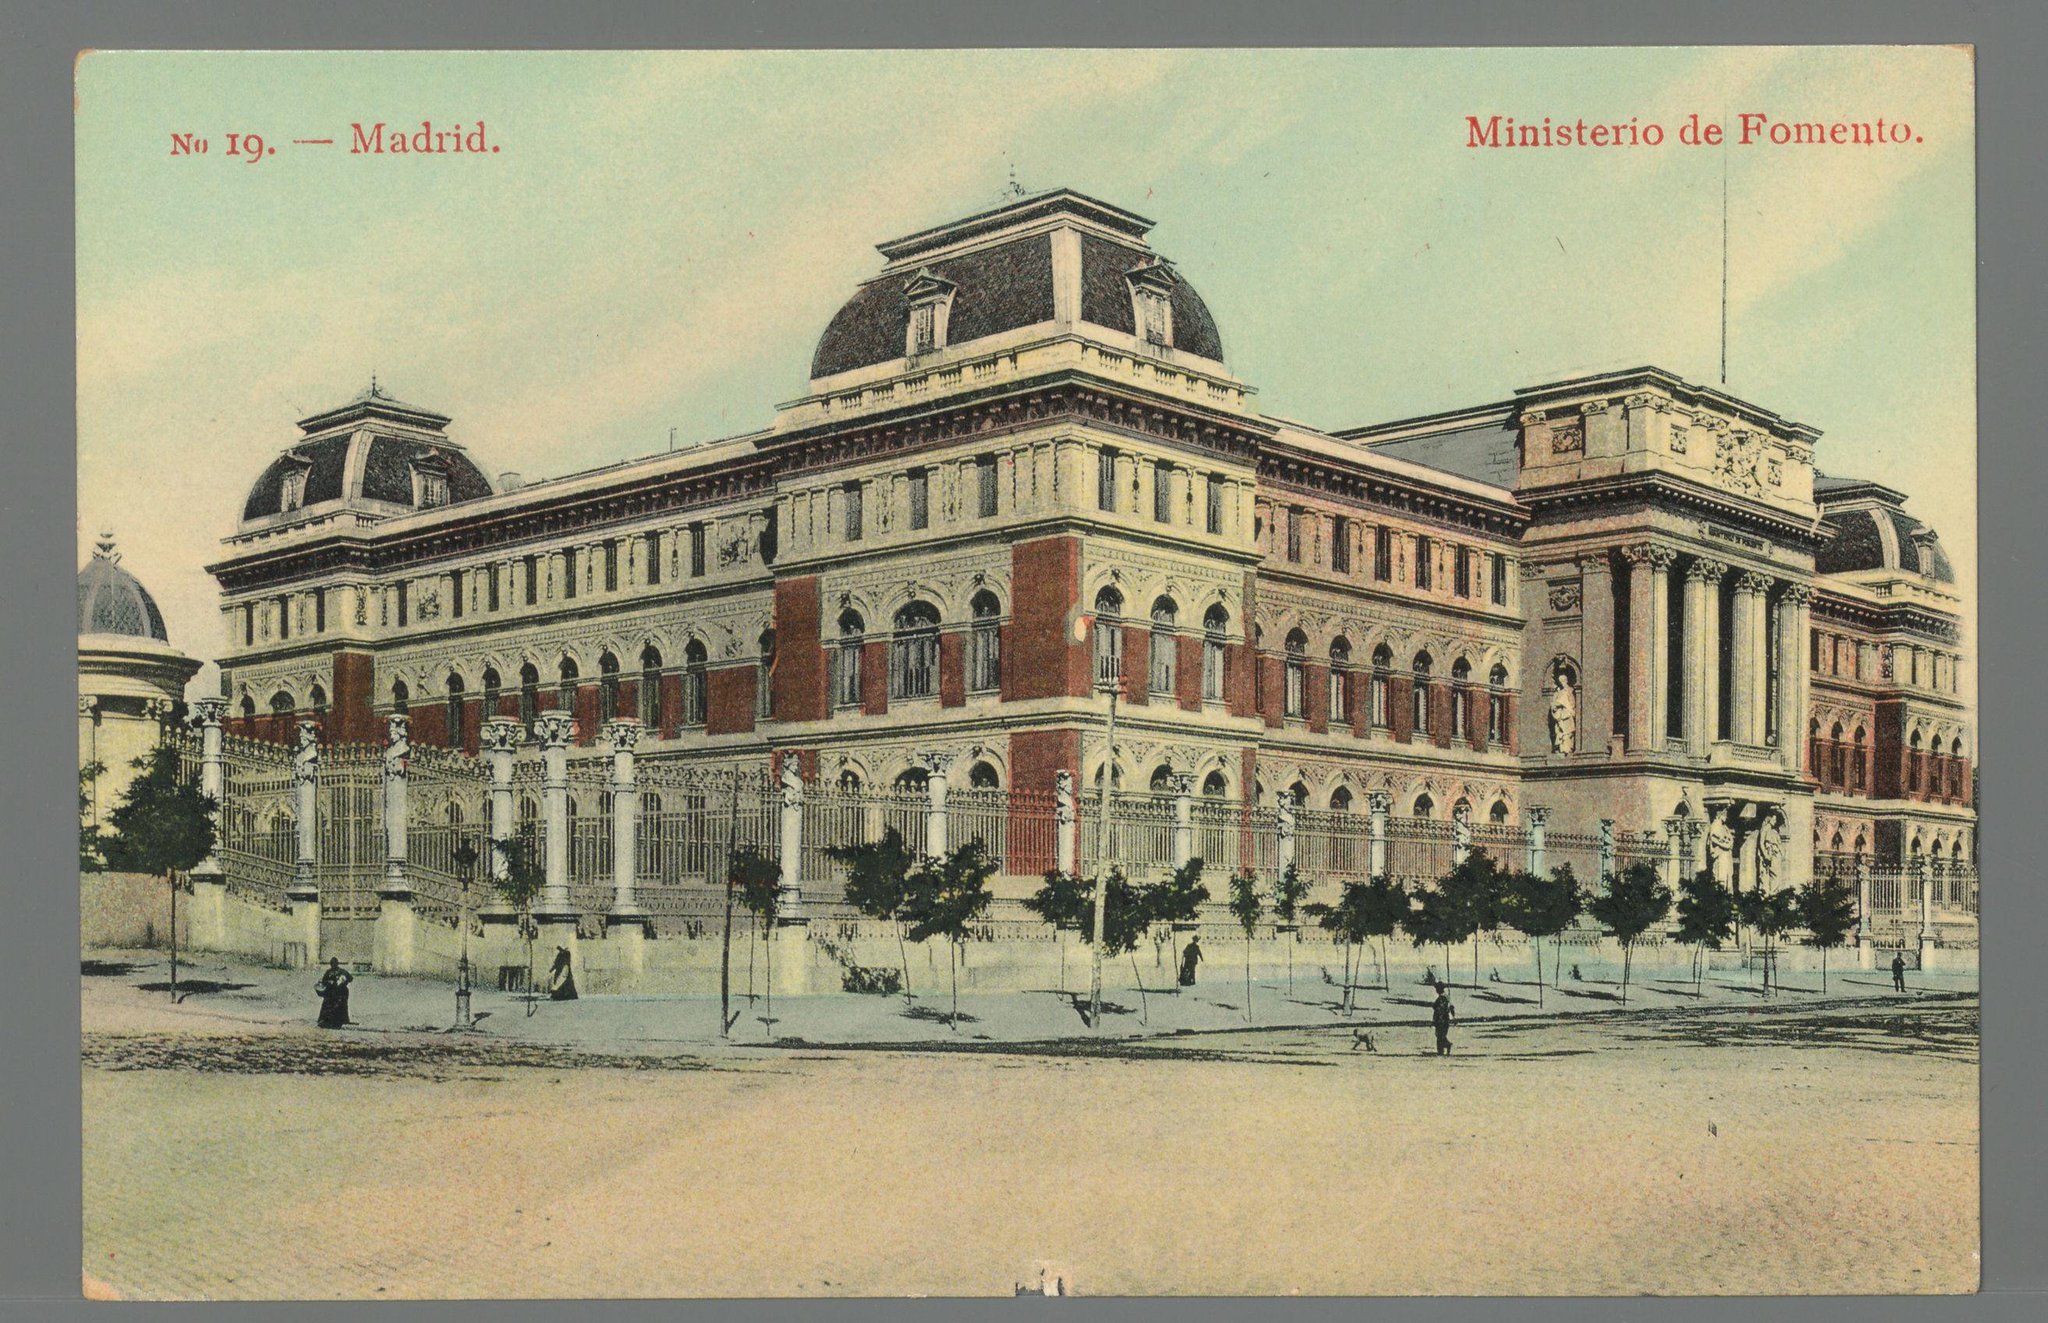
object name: ansichtkaart, prentbriefkaart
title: Madrid. Ministerio de Fomento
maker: Anonymous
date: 1906-1930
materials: cardboard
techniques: photograph, lithograph, writing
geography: madrid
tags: edifice, e.g.: public building, department store